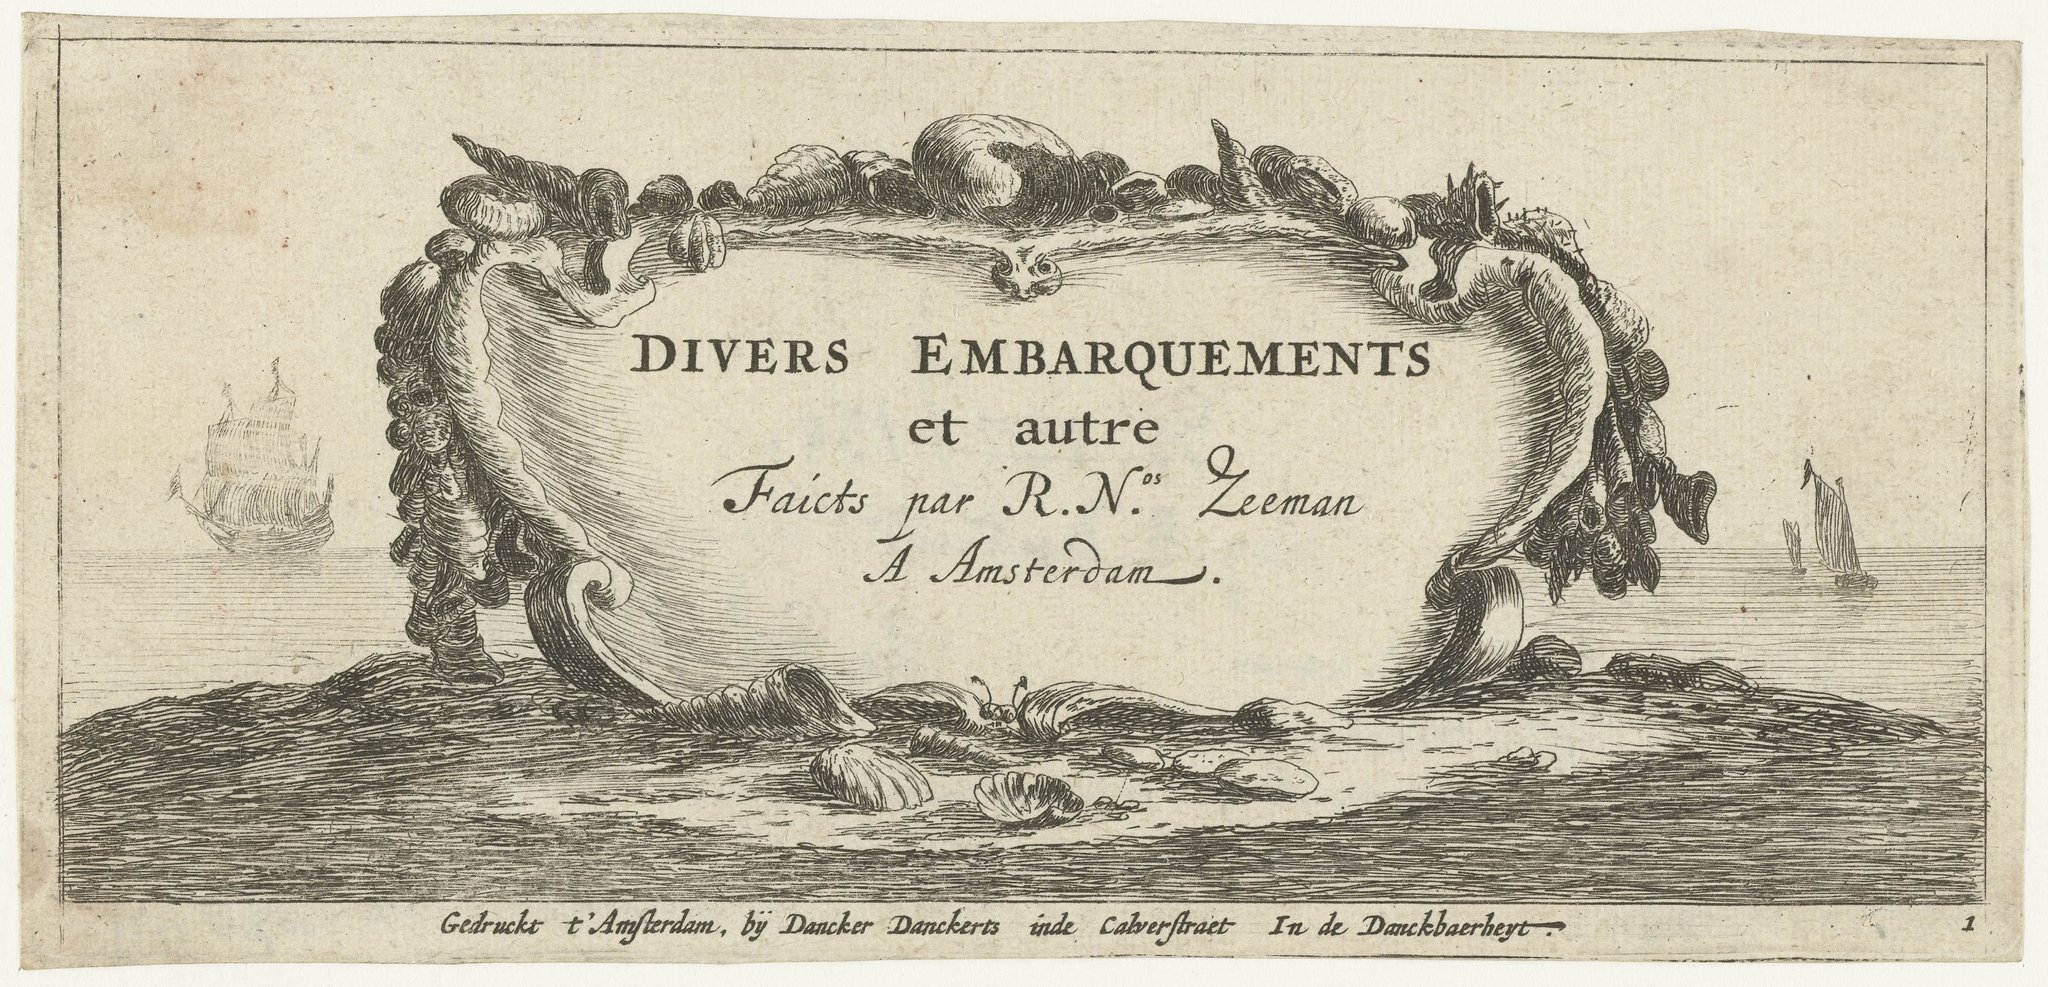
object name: print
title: Diverse inschepingen en dergelijken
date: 1651-1652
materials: paper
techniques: etching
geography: amsterdam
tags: ornament ~ cartouche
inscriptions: collector's mark: Lugt 2228, collector's mark: Lugt 567, collector's mark: Lugt 2760, collector's mark: ‘twee inelkaar grijpende C's’ Lugt 505 (?)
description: Titelblad van een serie van dertien prenten met verschillende inschepingen en zeegezichten. Cartouche omrand met schelpen, met vierregelige tekst in het Frans. Zee met twee zeilschepen op achtergrond.